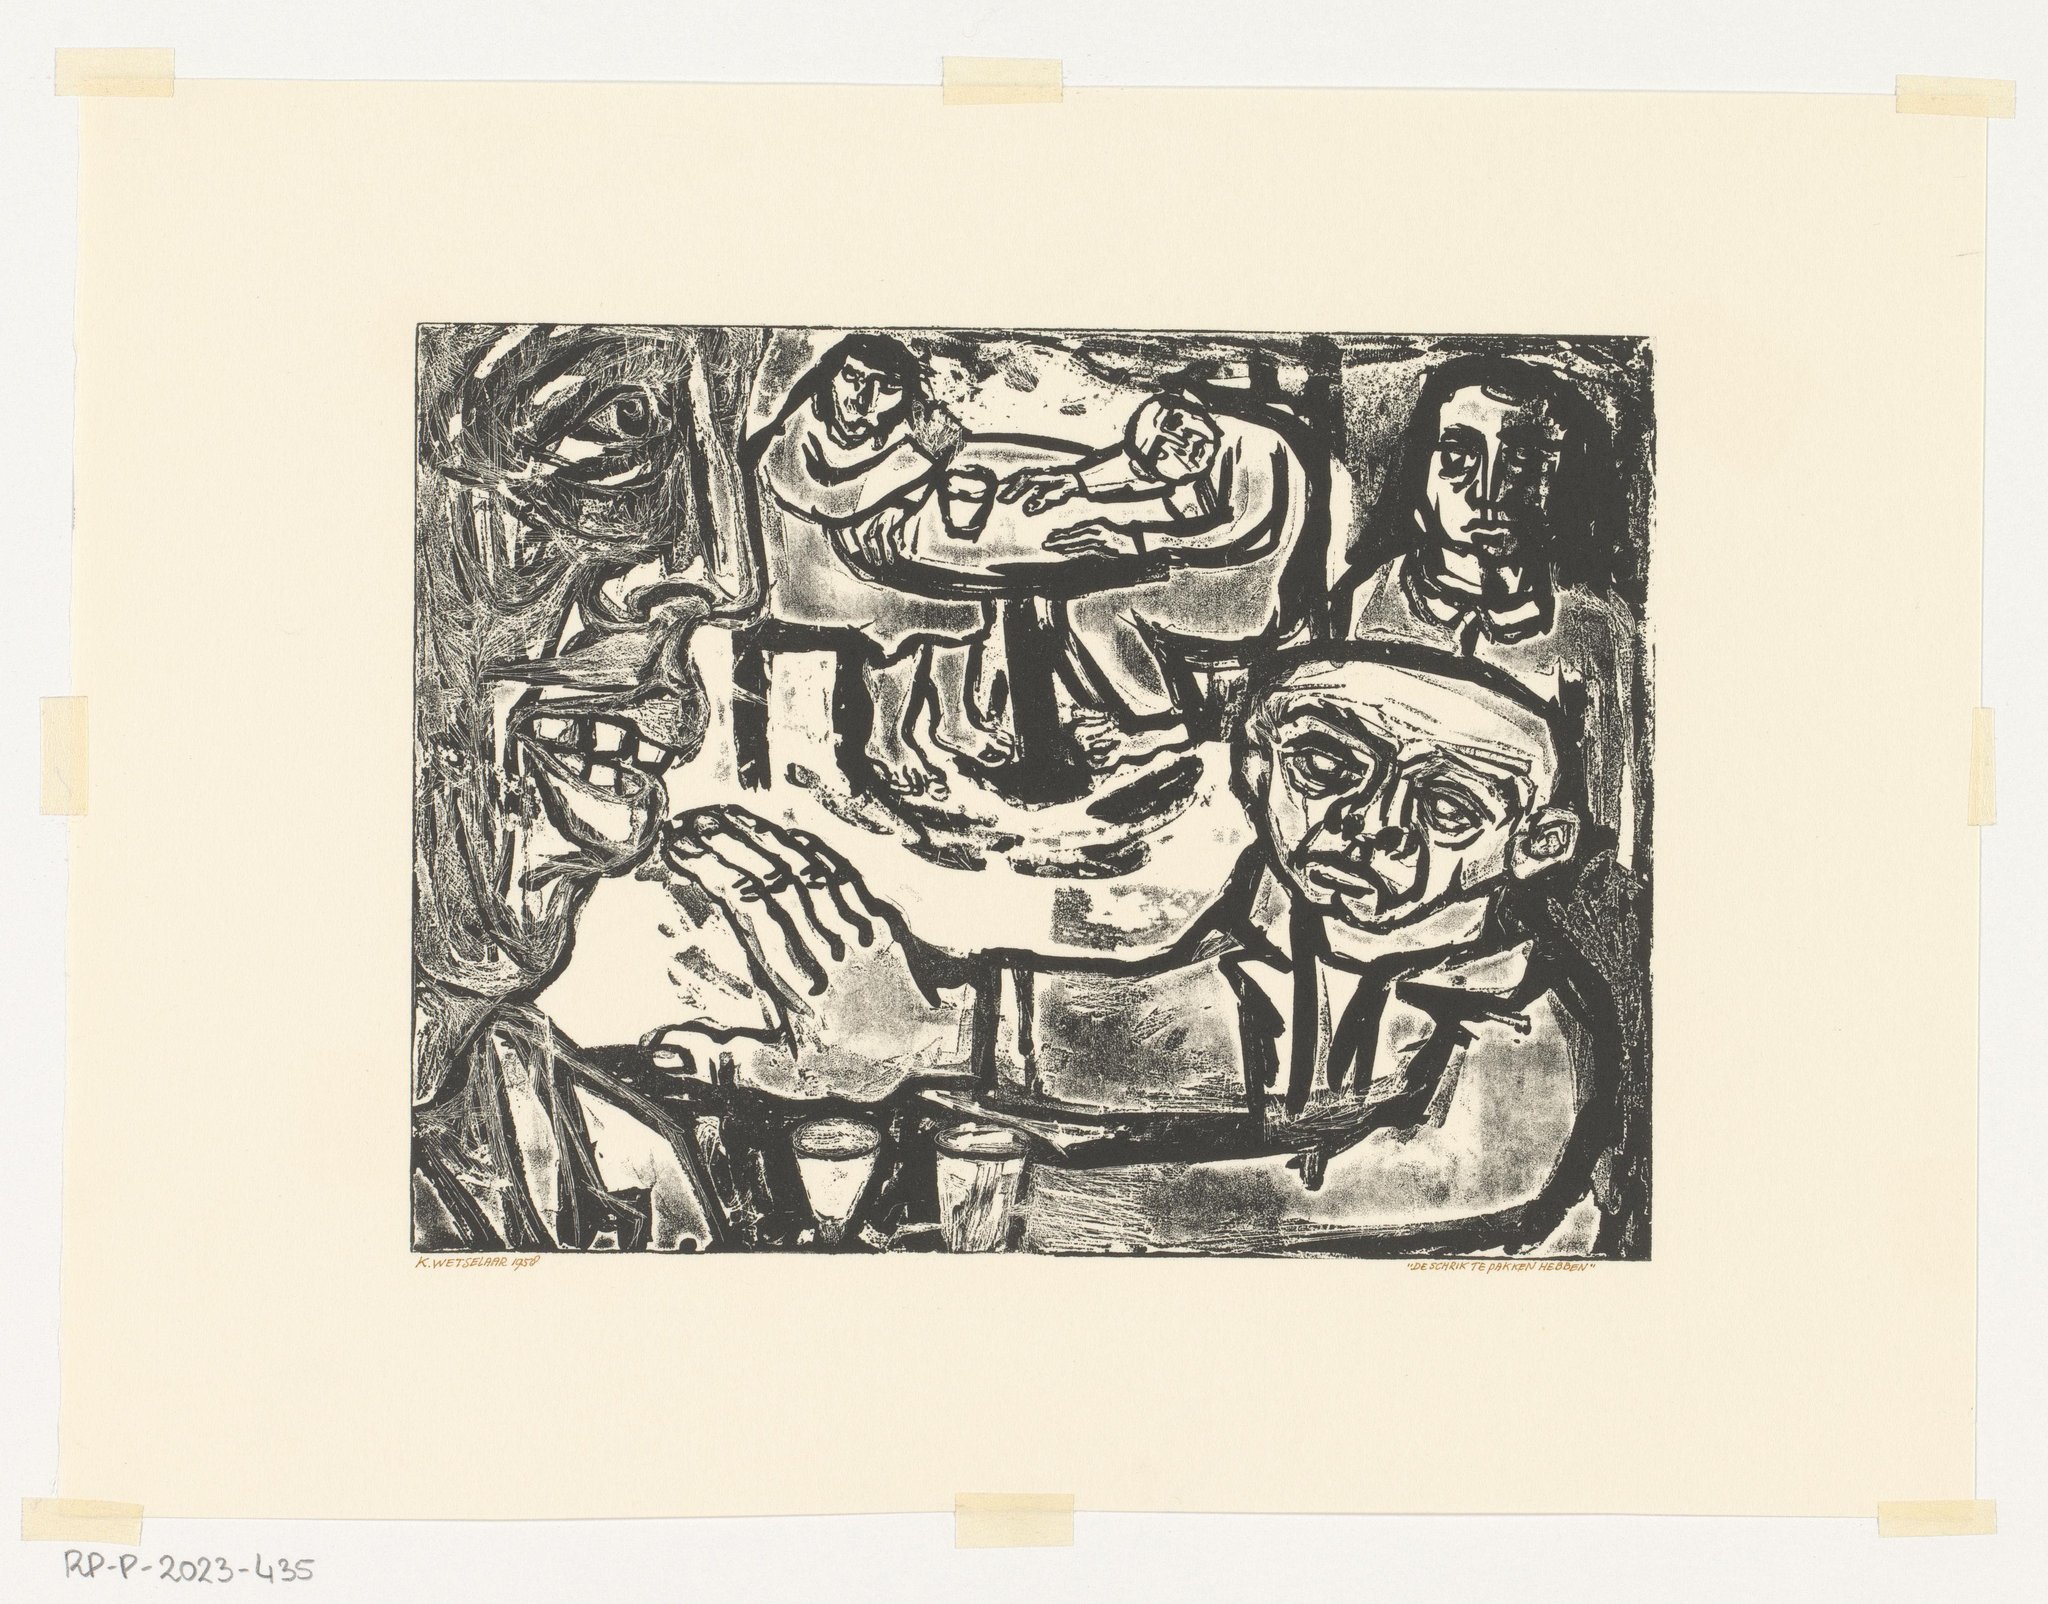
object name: print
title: De Schrik Te Pakken Hebben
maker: karel wetselaar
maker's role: print maker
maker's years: 1935-2017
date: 1958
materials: paper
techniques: intaglio, linocut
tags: inn, coffee-house, public house, etc.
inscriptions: signature and date: ‘K. Wetselaar 1958’